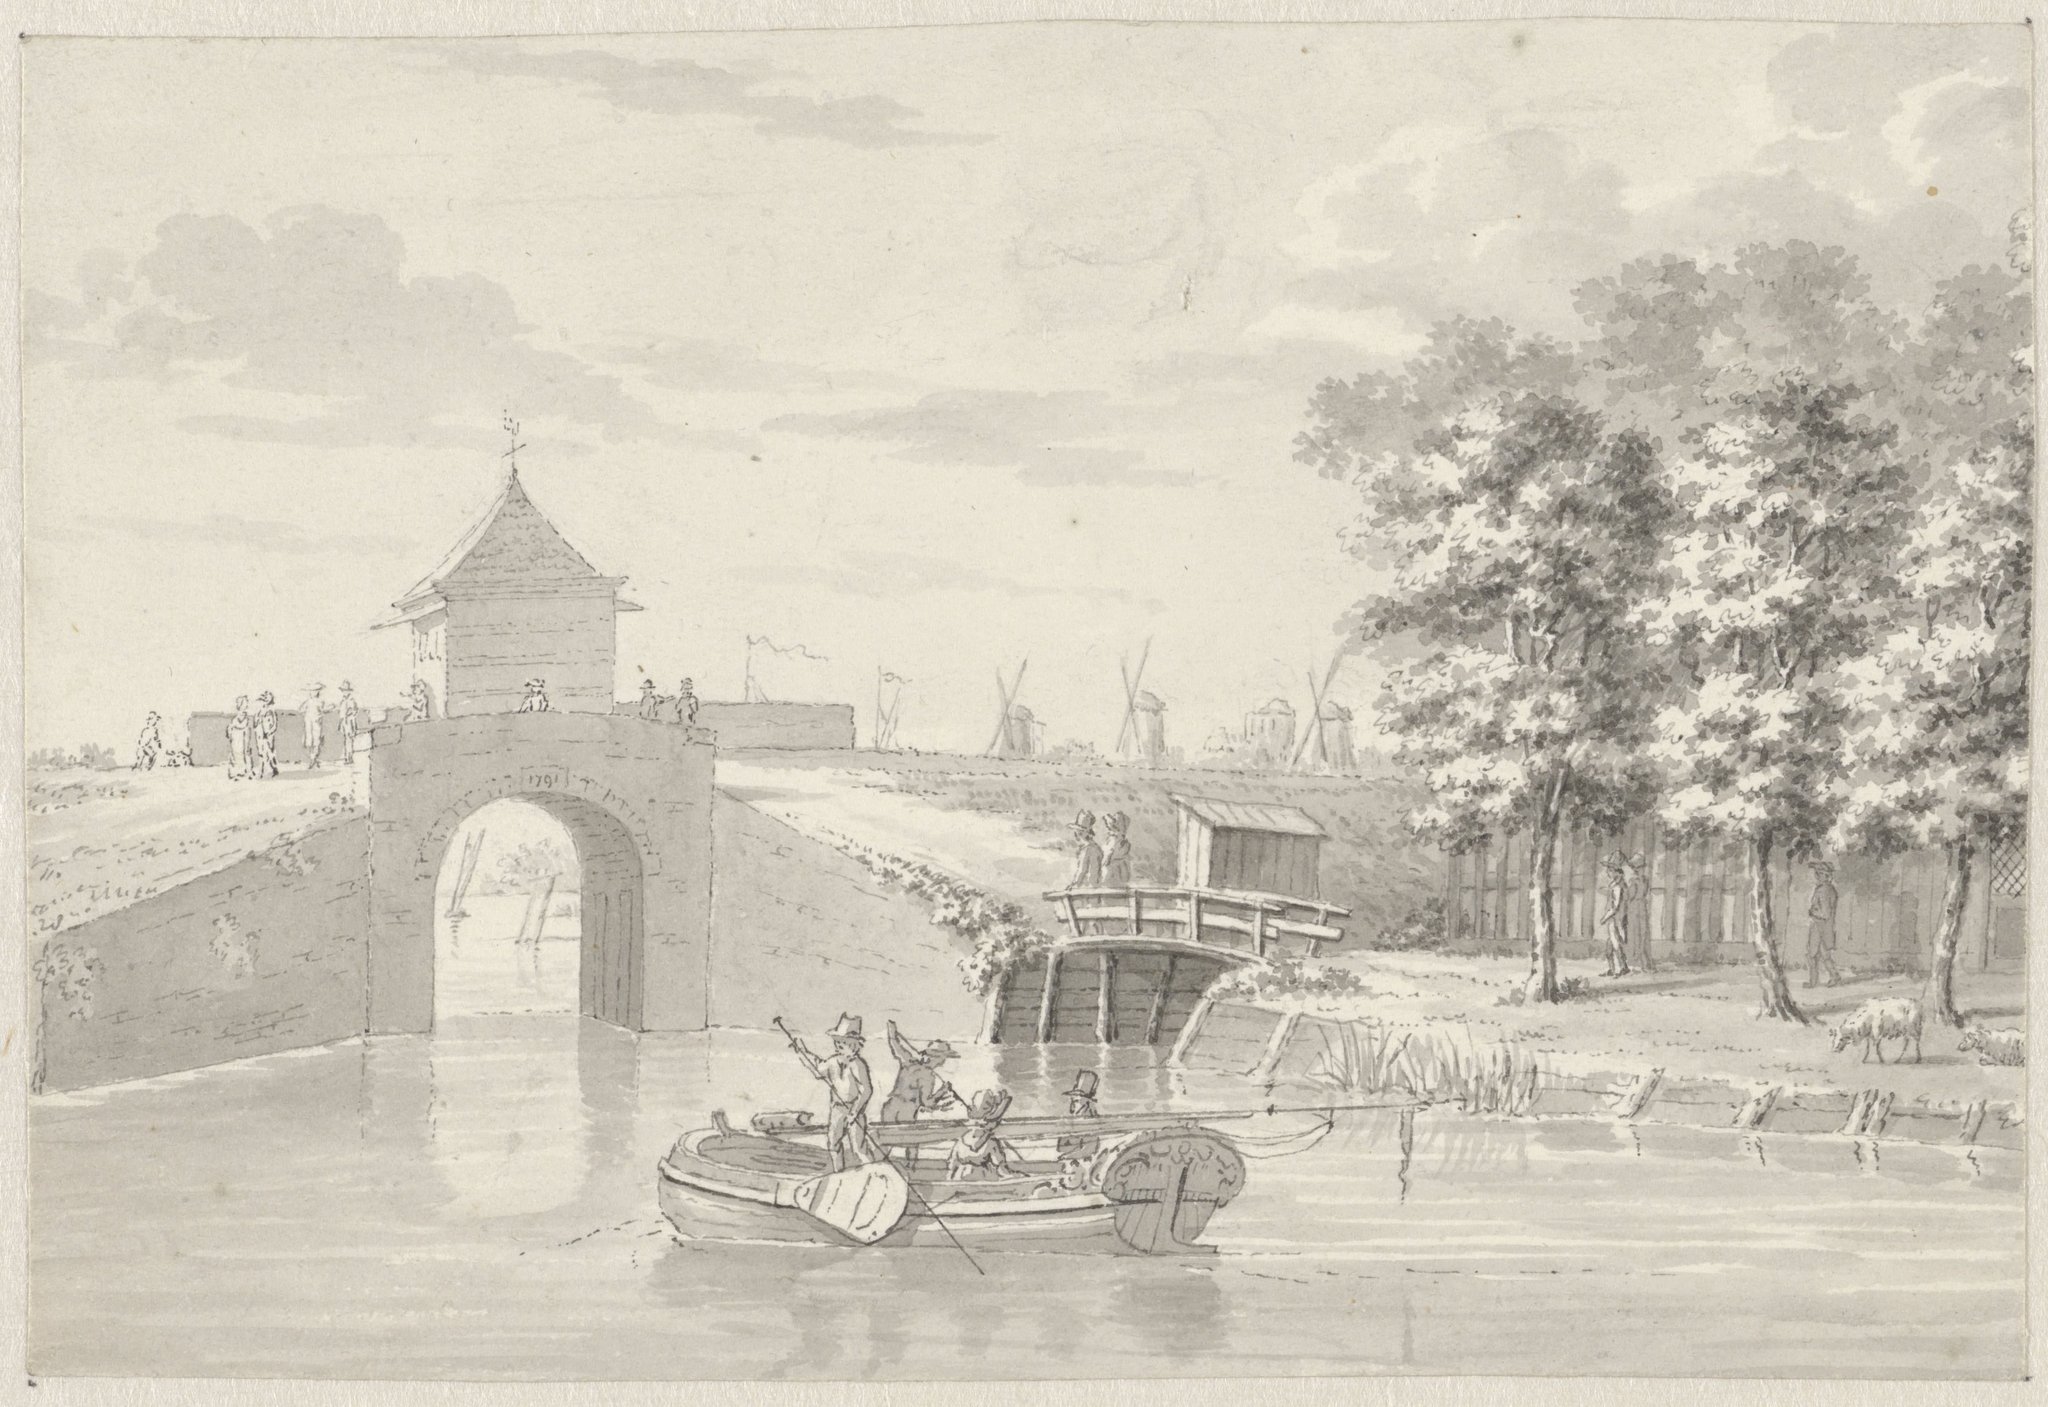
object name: drawing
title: Boot met vier personen bij een brug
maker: pieter de goeje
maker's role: draughtsman, print maker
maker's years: 1789-1859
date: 1789-1859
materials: ink, paper, pencil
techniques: brush, pen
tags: landscape with bridge, viaduct or aqueduct